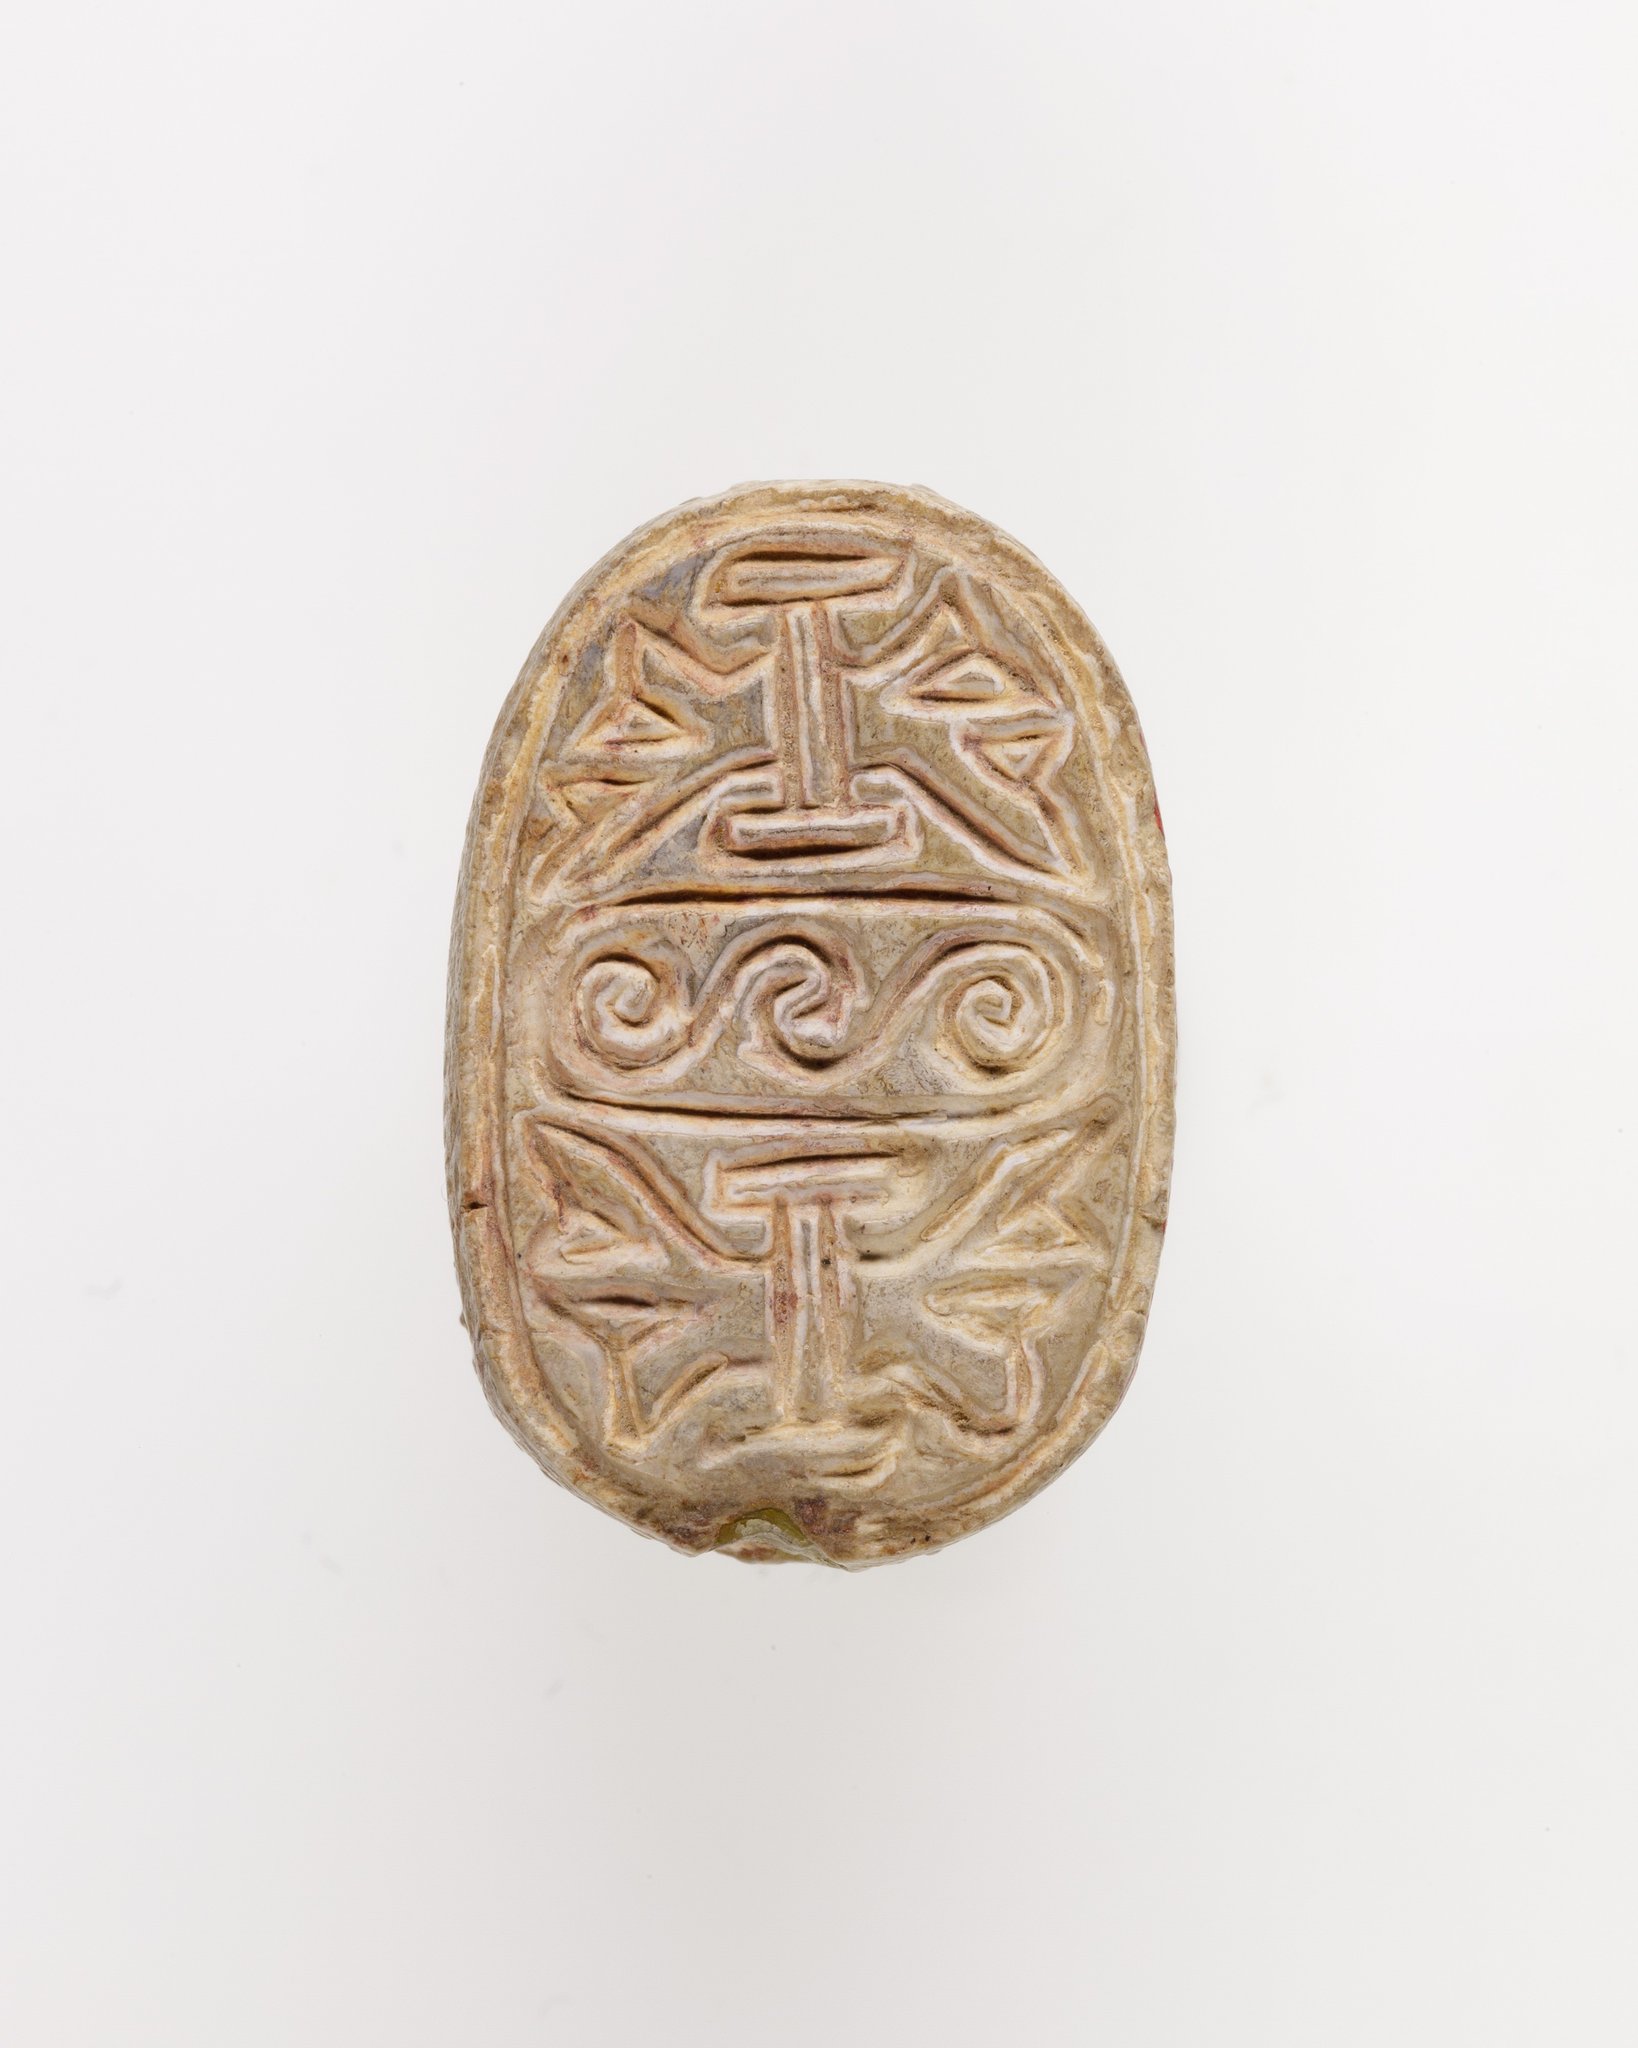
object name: scarab, sema tawy, scroll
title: Scarab Decorated with the Symbol of Unification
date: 1850-1640 BCE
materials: stone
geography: egypt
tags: scarabs